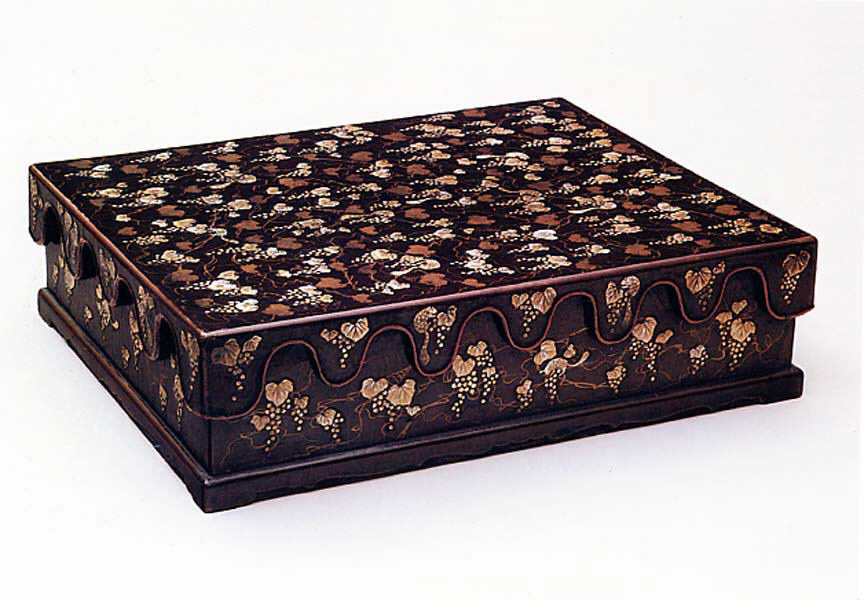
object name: stationery box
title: Stationery box with decoration of grapes and squirrels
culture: japanese or ryukyuan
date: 1601-1700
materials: gold, lacquer, mother of pearl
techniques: inlay, painting